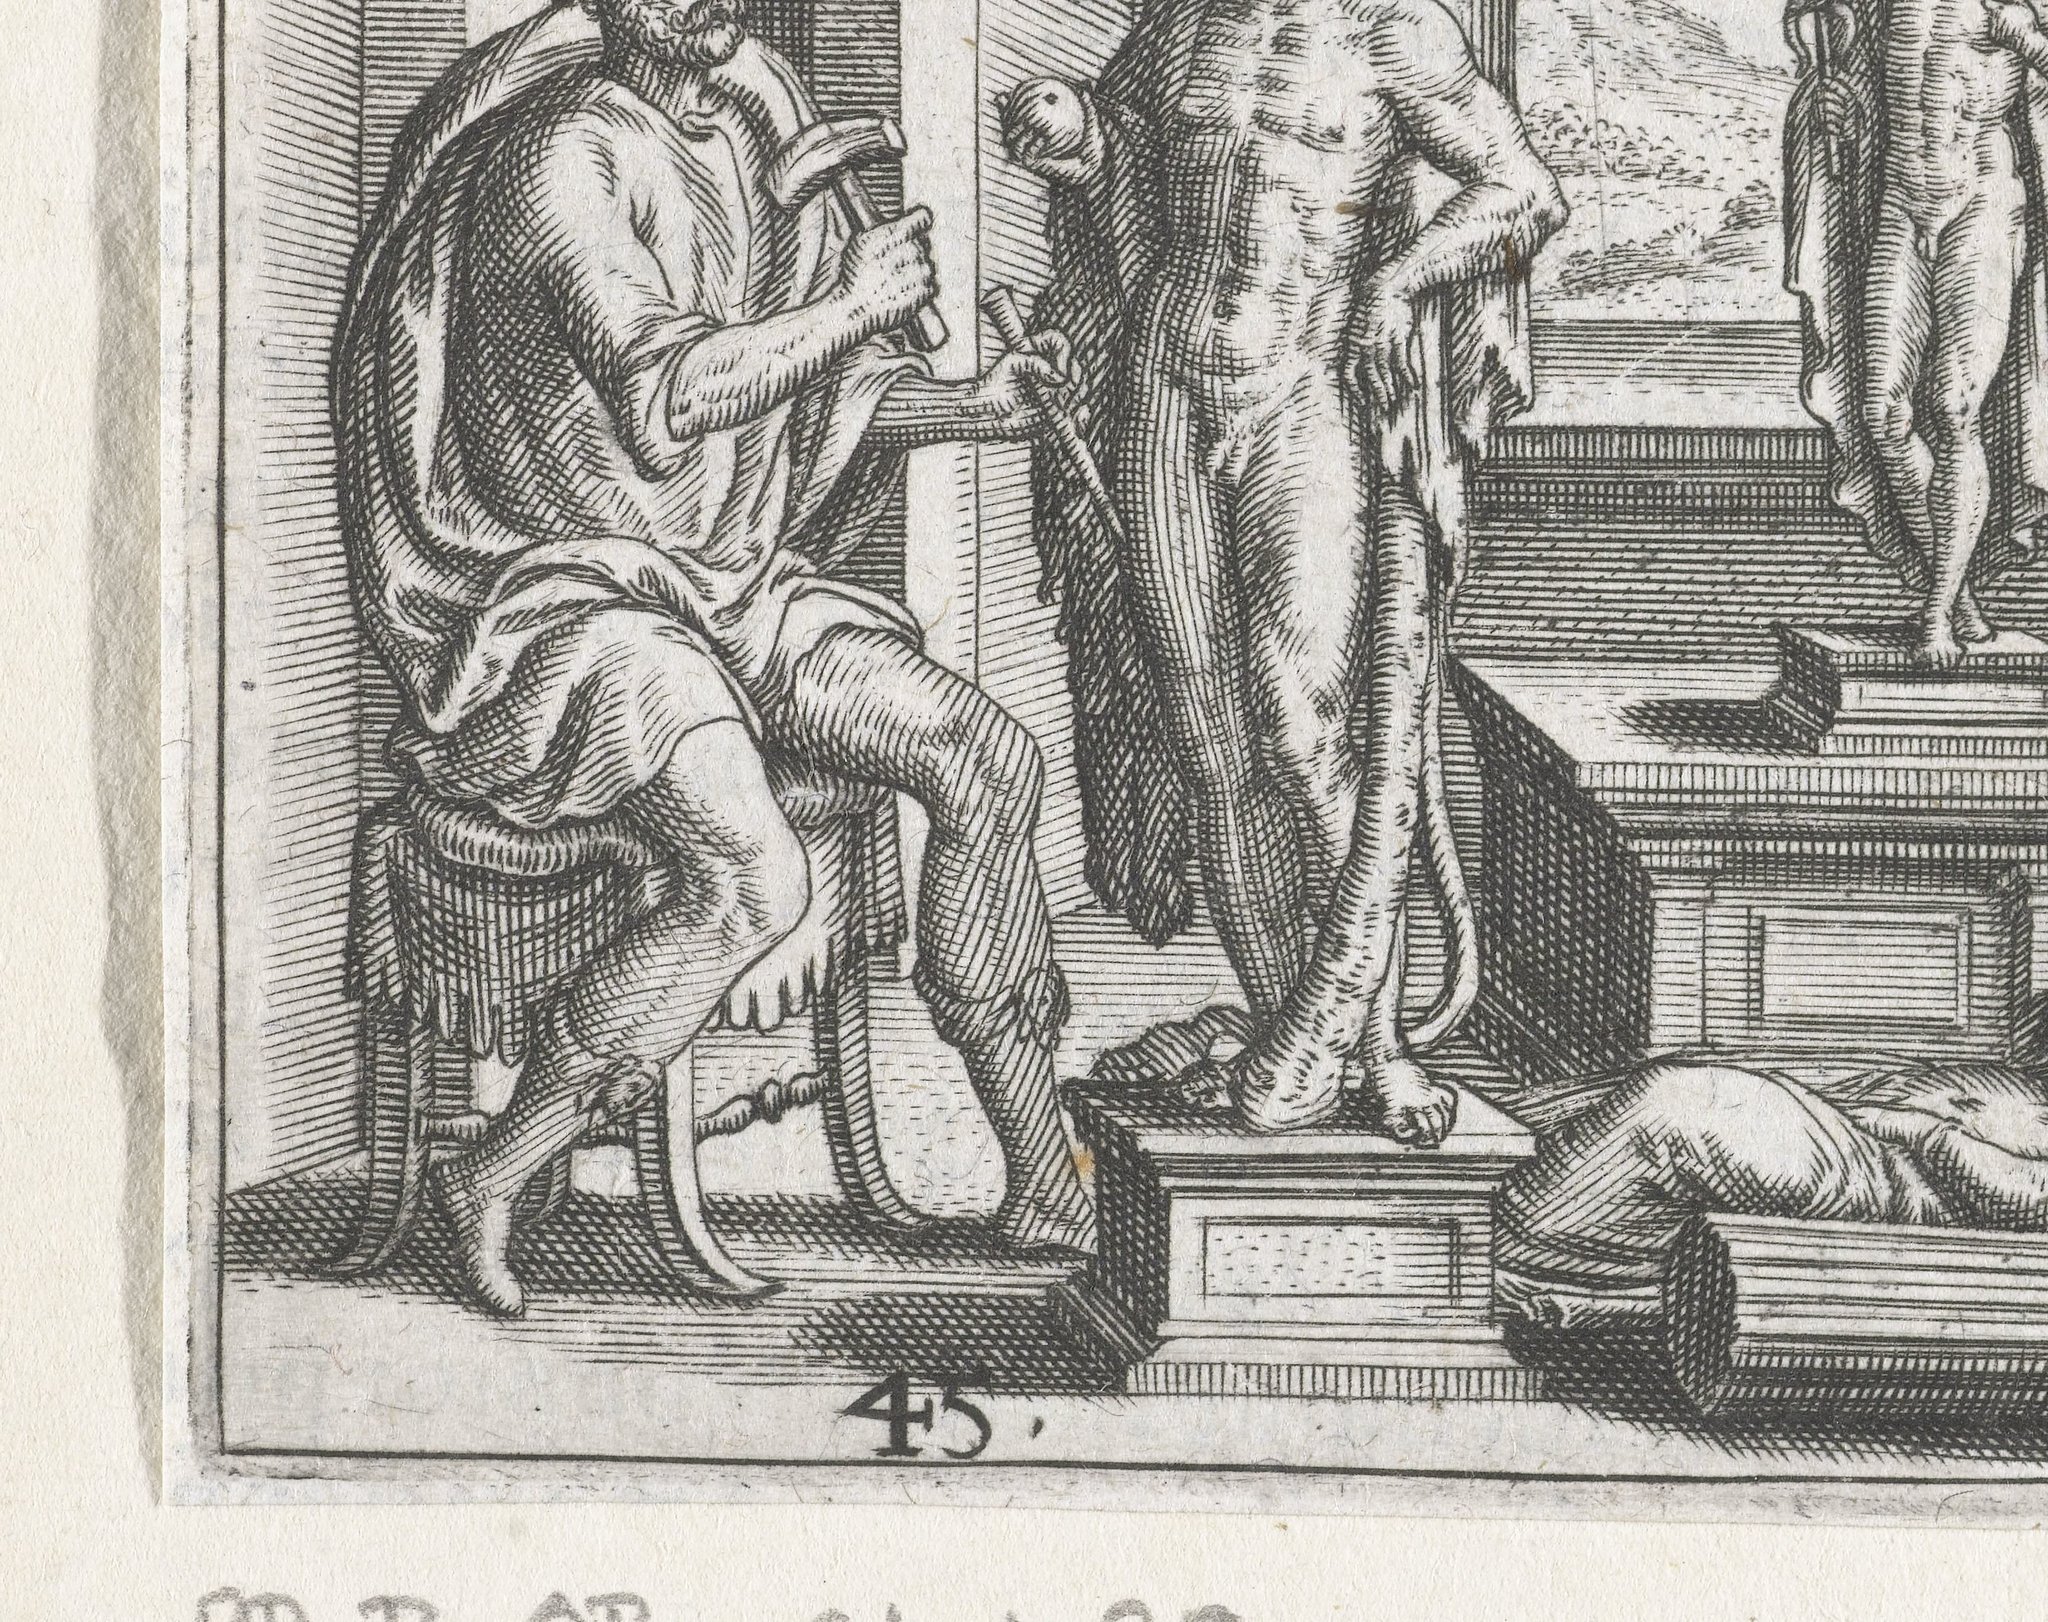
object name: cognizance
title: DIGNA LABORATIS RESPONDET PRAEMIA CVRIS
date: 1596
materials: paper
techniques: engraving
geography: frankfurt am main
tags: sculptor at work (+ in workshop or studio)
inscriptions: collector's mark: Lugt 240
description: Een beeldhouwer is in zijn werkplaats bezig met het maken van een beeld van de god Hercules. Op een tafel staan al beelden van Mercurius en een beeld van een vrouw.